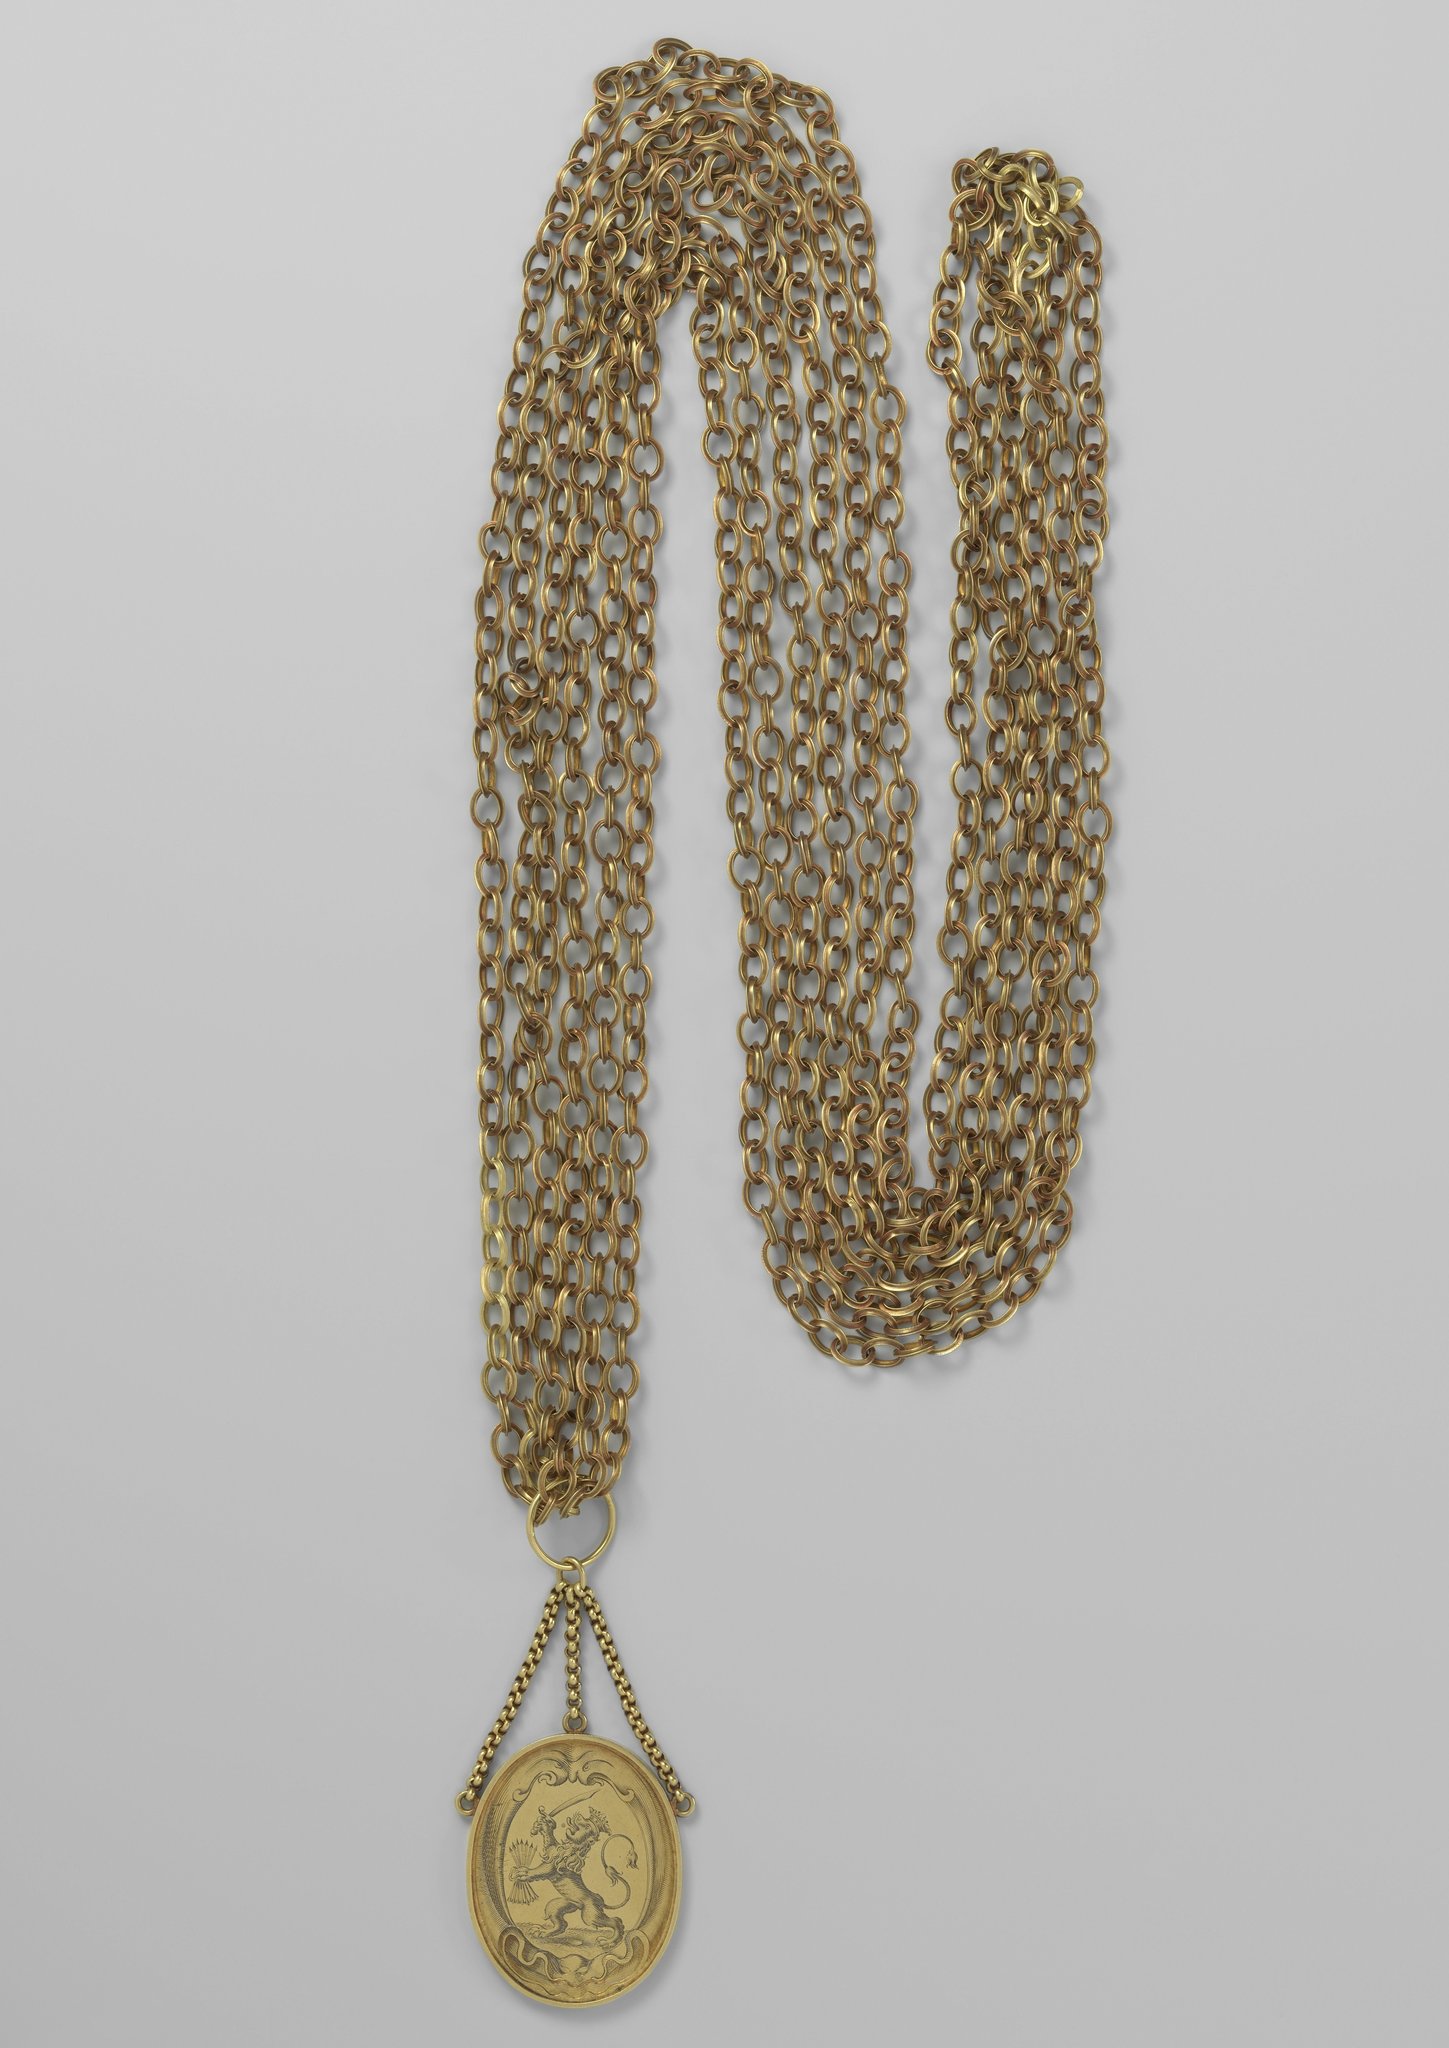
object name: honorary medal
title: Medal of honour for Michiel de Ruyter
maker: Anonymous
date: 1657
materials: gold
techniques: engraving, forging, striking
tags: flushing, michiel adriaenszoon de ruyter, coat of arms (as symbol of the state, etc.), amsterdam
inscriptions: duty mark, inscription: ‘A A’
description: In 1657 Admiral de Ruyter was awarded a medal of honour by the Admiralty of Amsterdam, the headquarters of the Dutch navy, following his capture of two French privateers off the coast of Corsica. On the front is the lion of Holland, on the back the arms of the Admiralty, a lion behind a fence gripping two anchors. Both medal and chain are made of gold.